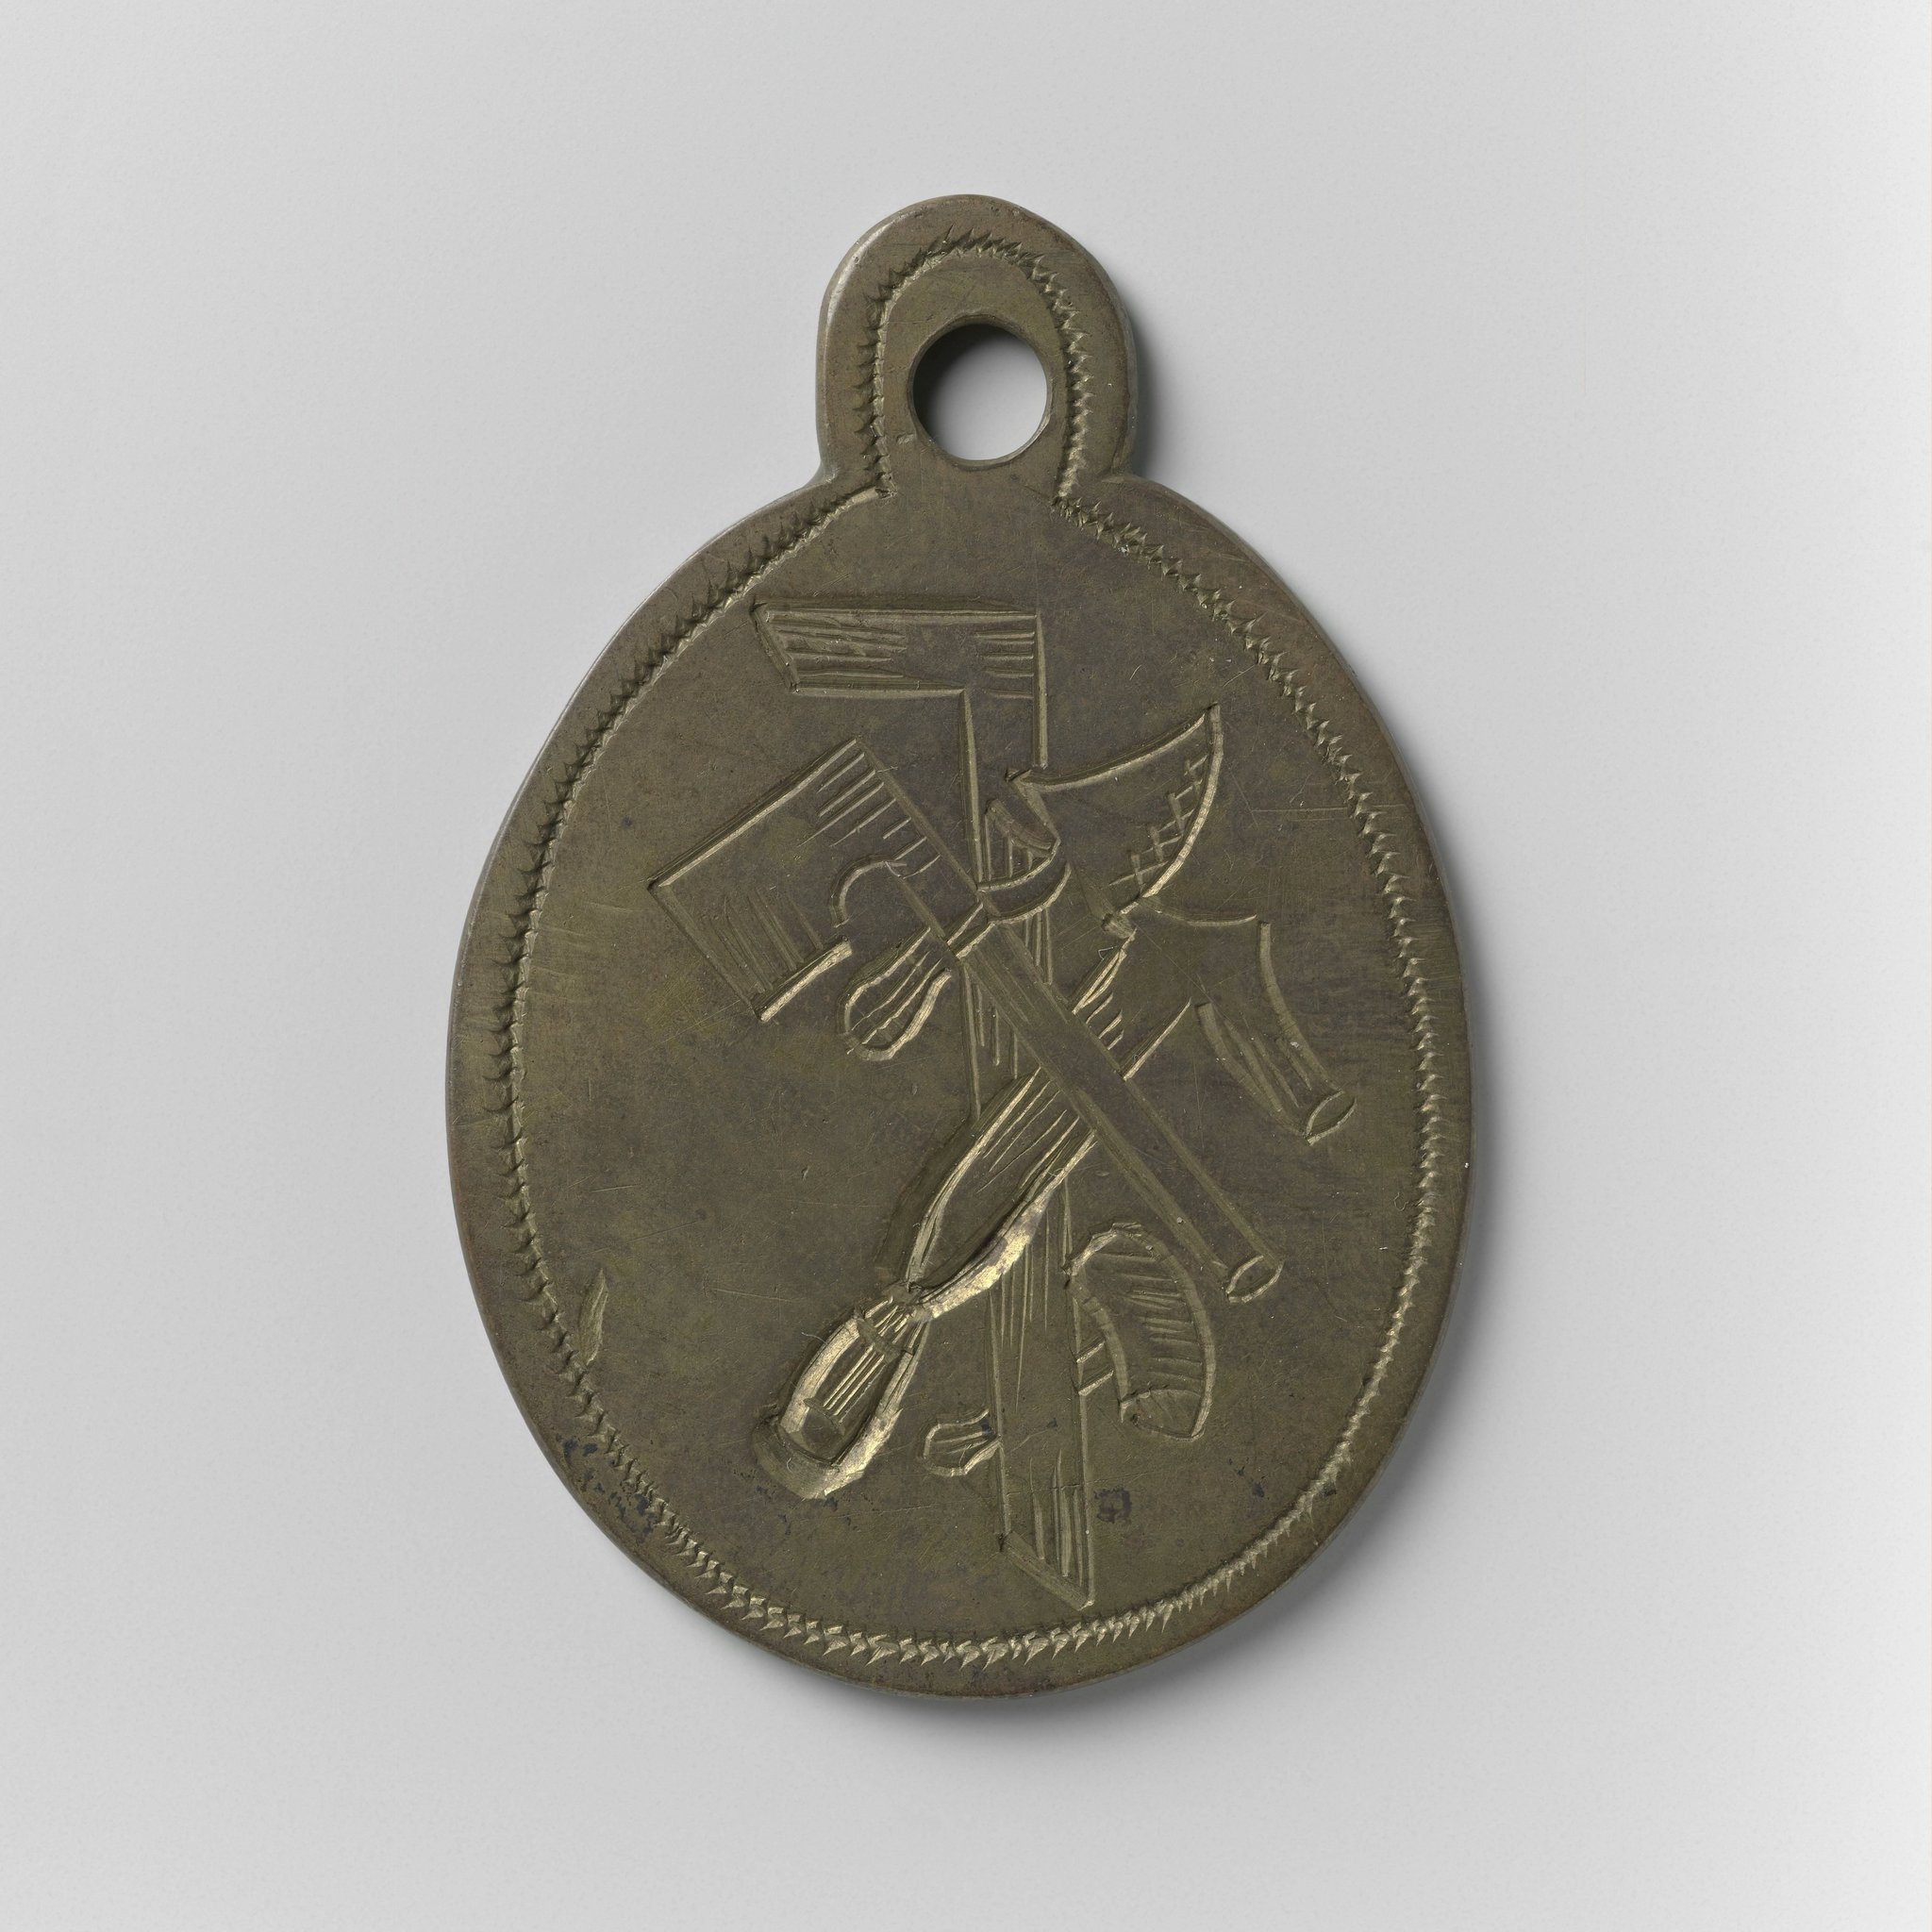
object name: medal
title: Timmerlieden-, metselaars-, loodgieters-, steenhouwers- en straatmakersgilde van 's-Hertogenbosch, gildepenning van Jan van Summeren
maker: Anonymous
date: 1789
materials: brass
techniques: engraving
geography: den bosch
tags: den bosch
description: Messing ovale penning aan draagoog. Voorzijde: tot trophe verenigde winkelhaak, bijl, troffel, loodgieters- en steenhouwershamer. Keerzijde: opschrift